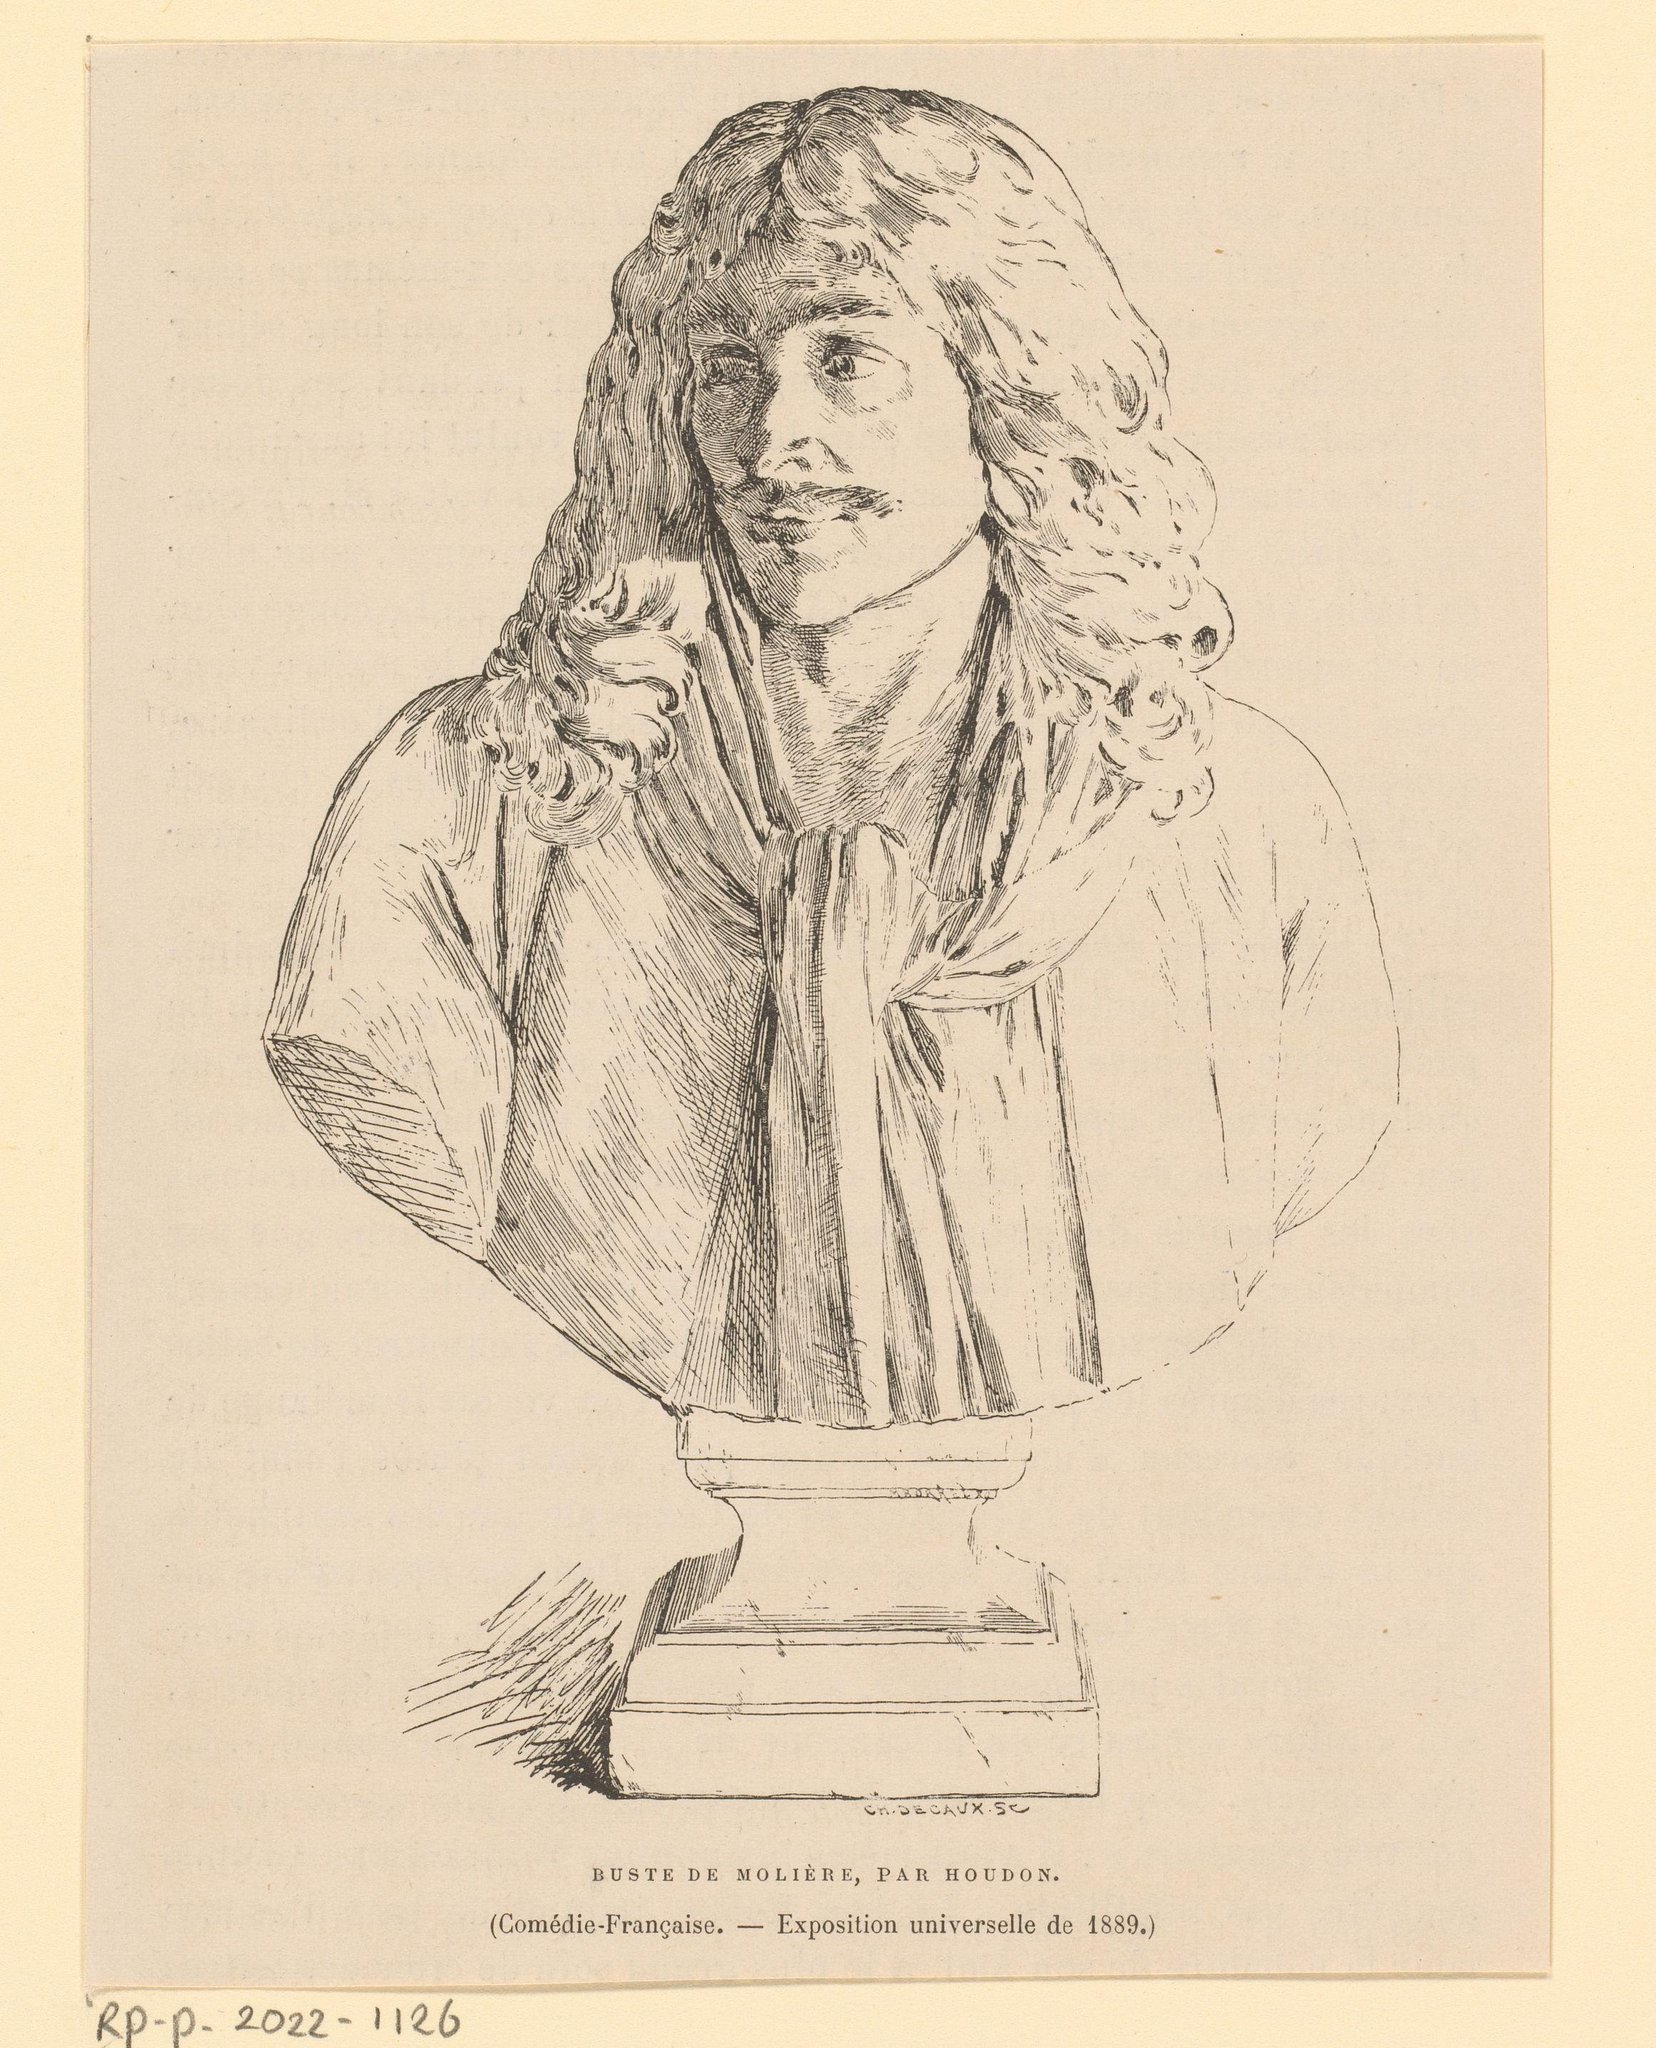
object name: print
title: Buste de Molière, par Houdon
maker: charles decaux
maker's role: print maker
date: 1889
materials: paper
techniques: letterpress printing, engraving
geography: sceaux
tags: jean baptiste poquelin molière, historical persons, writer, poet, author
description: Prent uit: Gazette des Beaux-Arts 3 (1889), 31e jaargang.